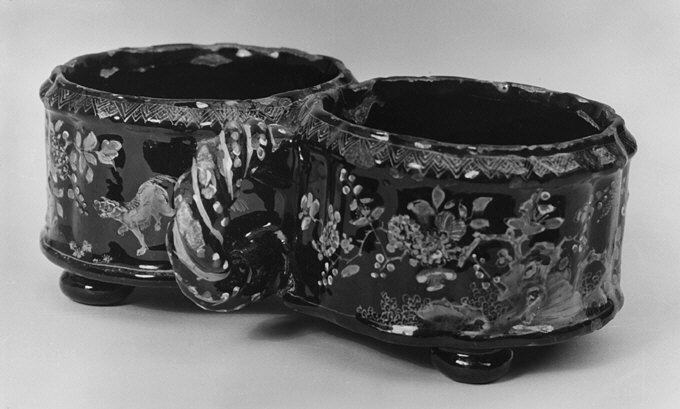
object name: oil and vinegar frame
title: Frame for oil and vinegar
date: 1701-1733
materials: earthenware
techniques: glazing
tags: animals,flowers